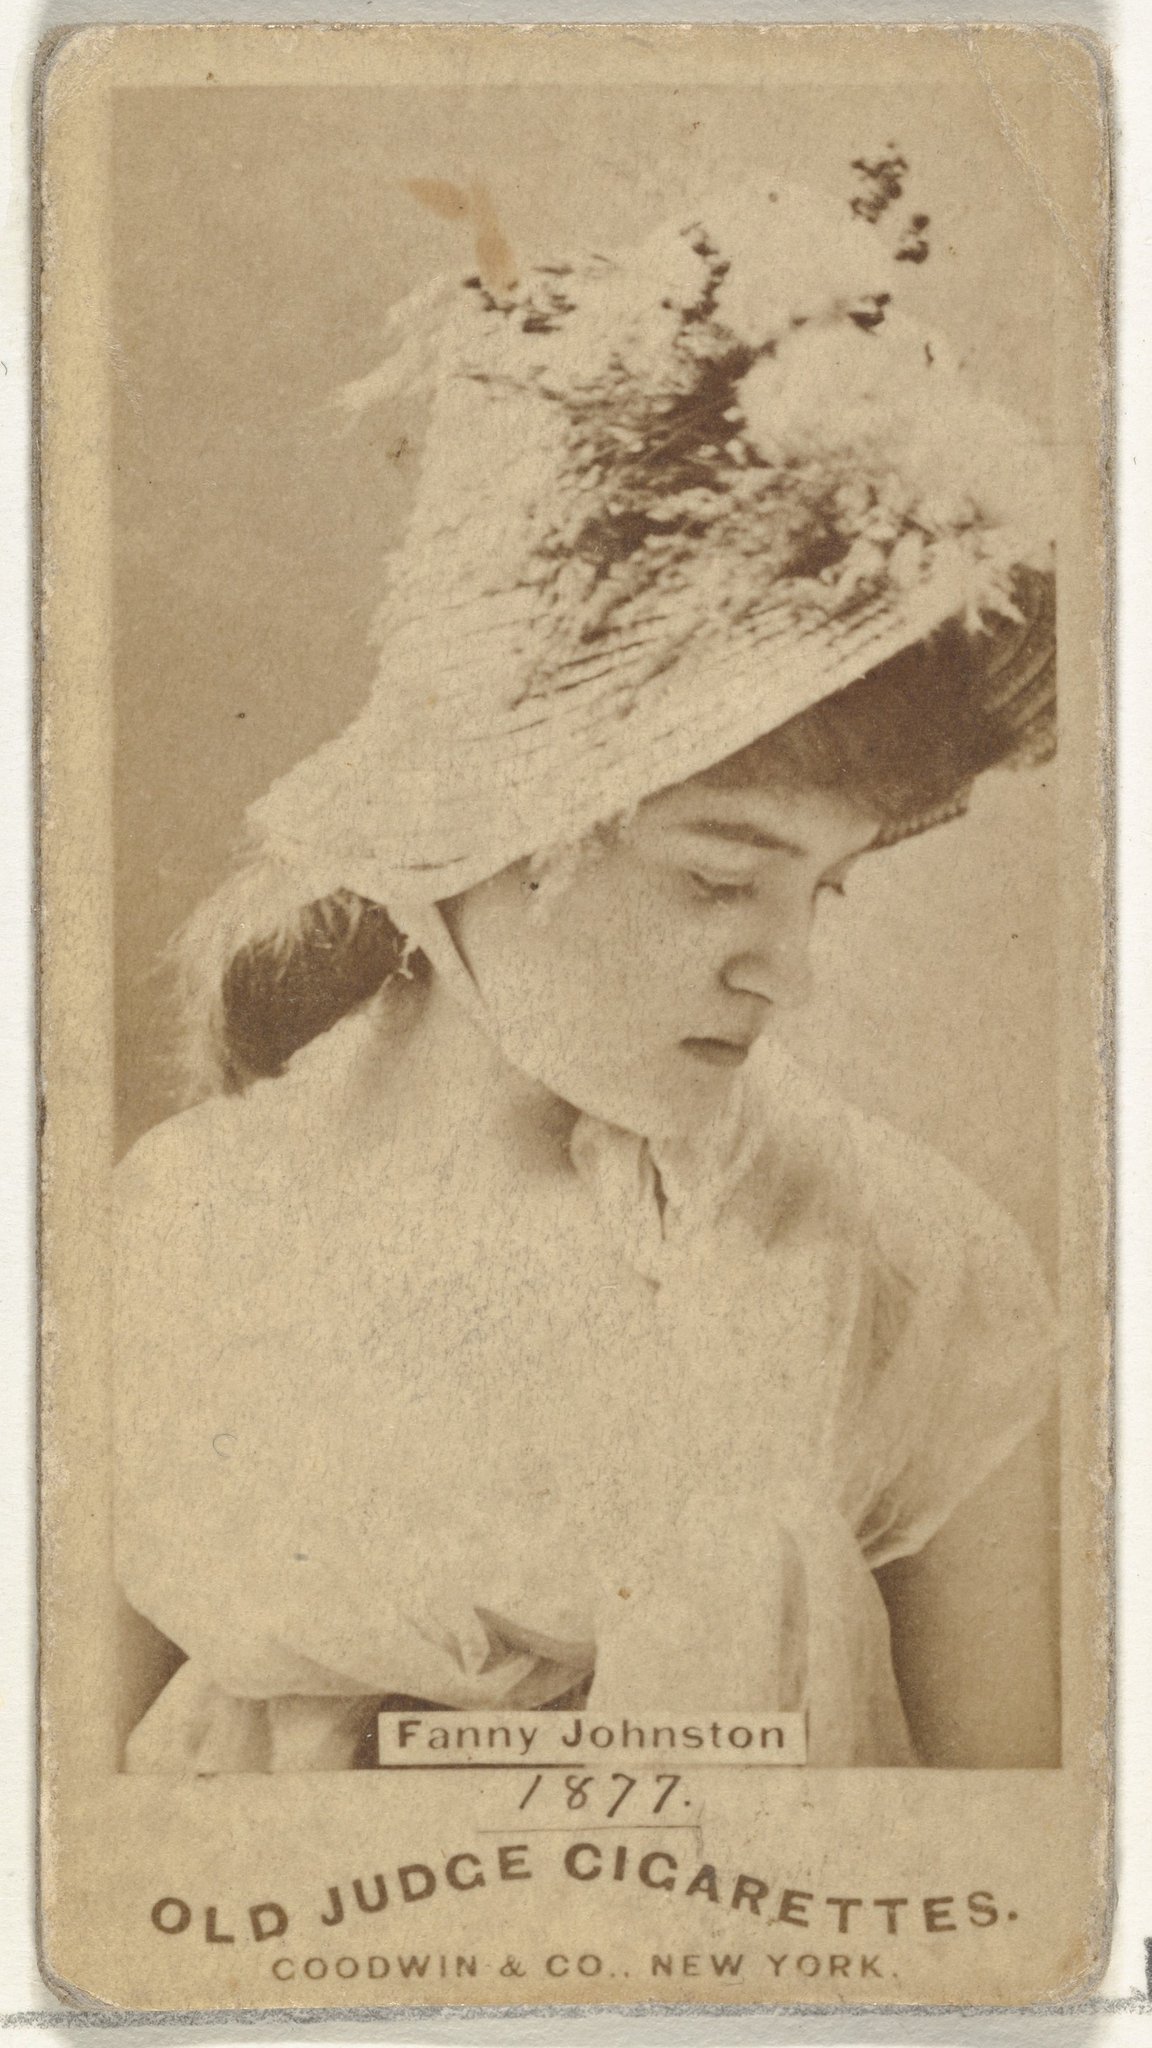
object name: photograph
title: Fanny Johnston, from the Actors and Actresses series (N171) for Old Judge Cigarettes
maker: goodwin & company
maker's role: publisher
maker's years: 1850-1950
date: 1886-1890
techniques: albumen silver print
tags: portraits,women,actresses